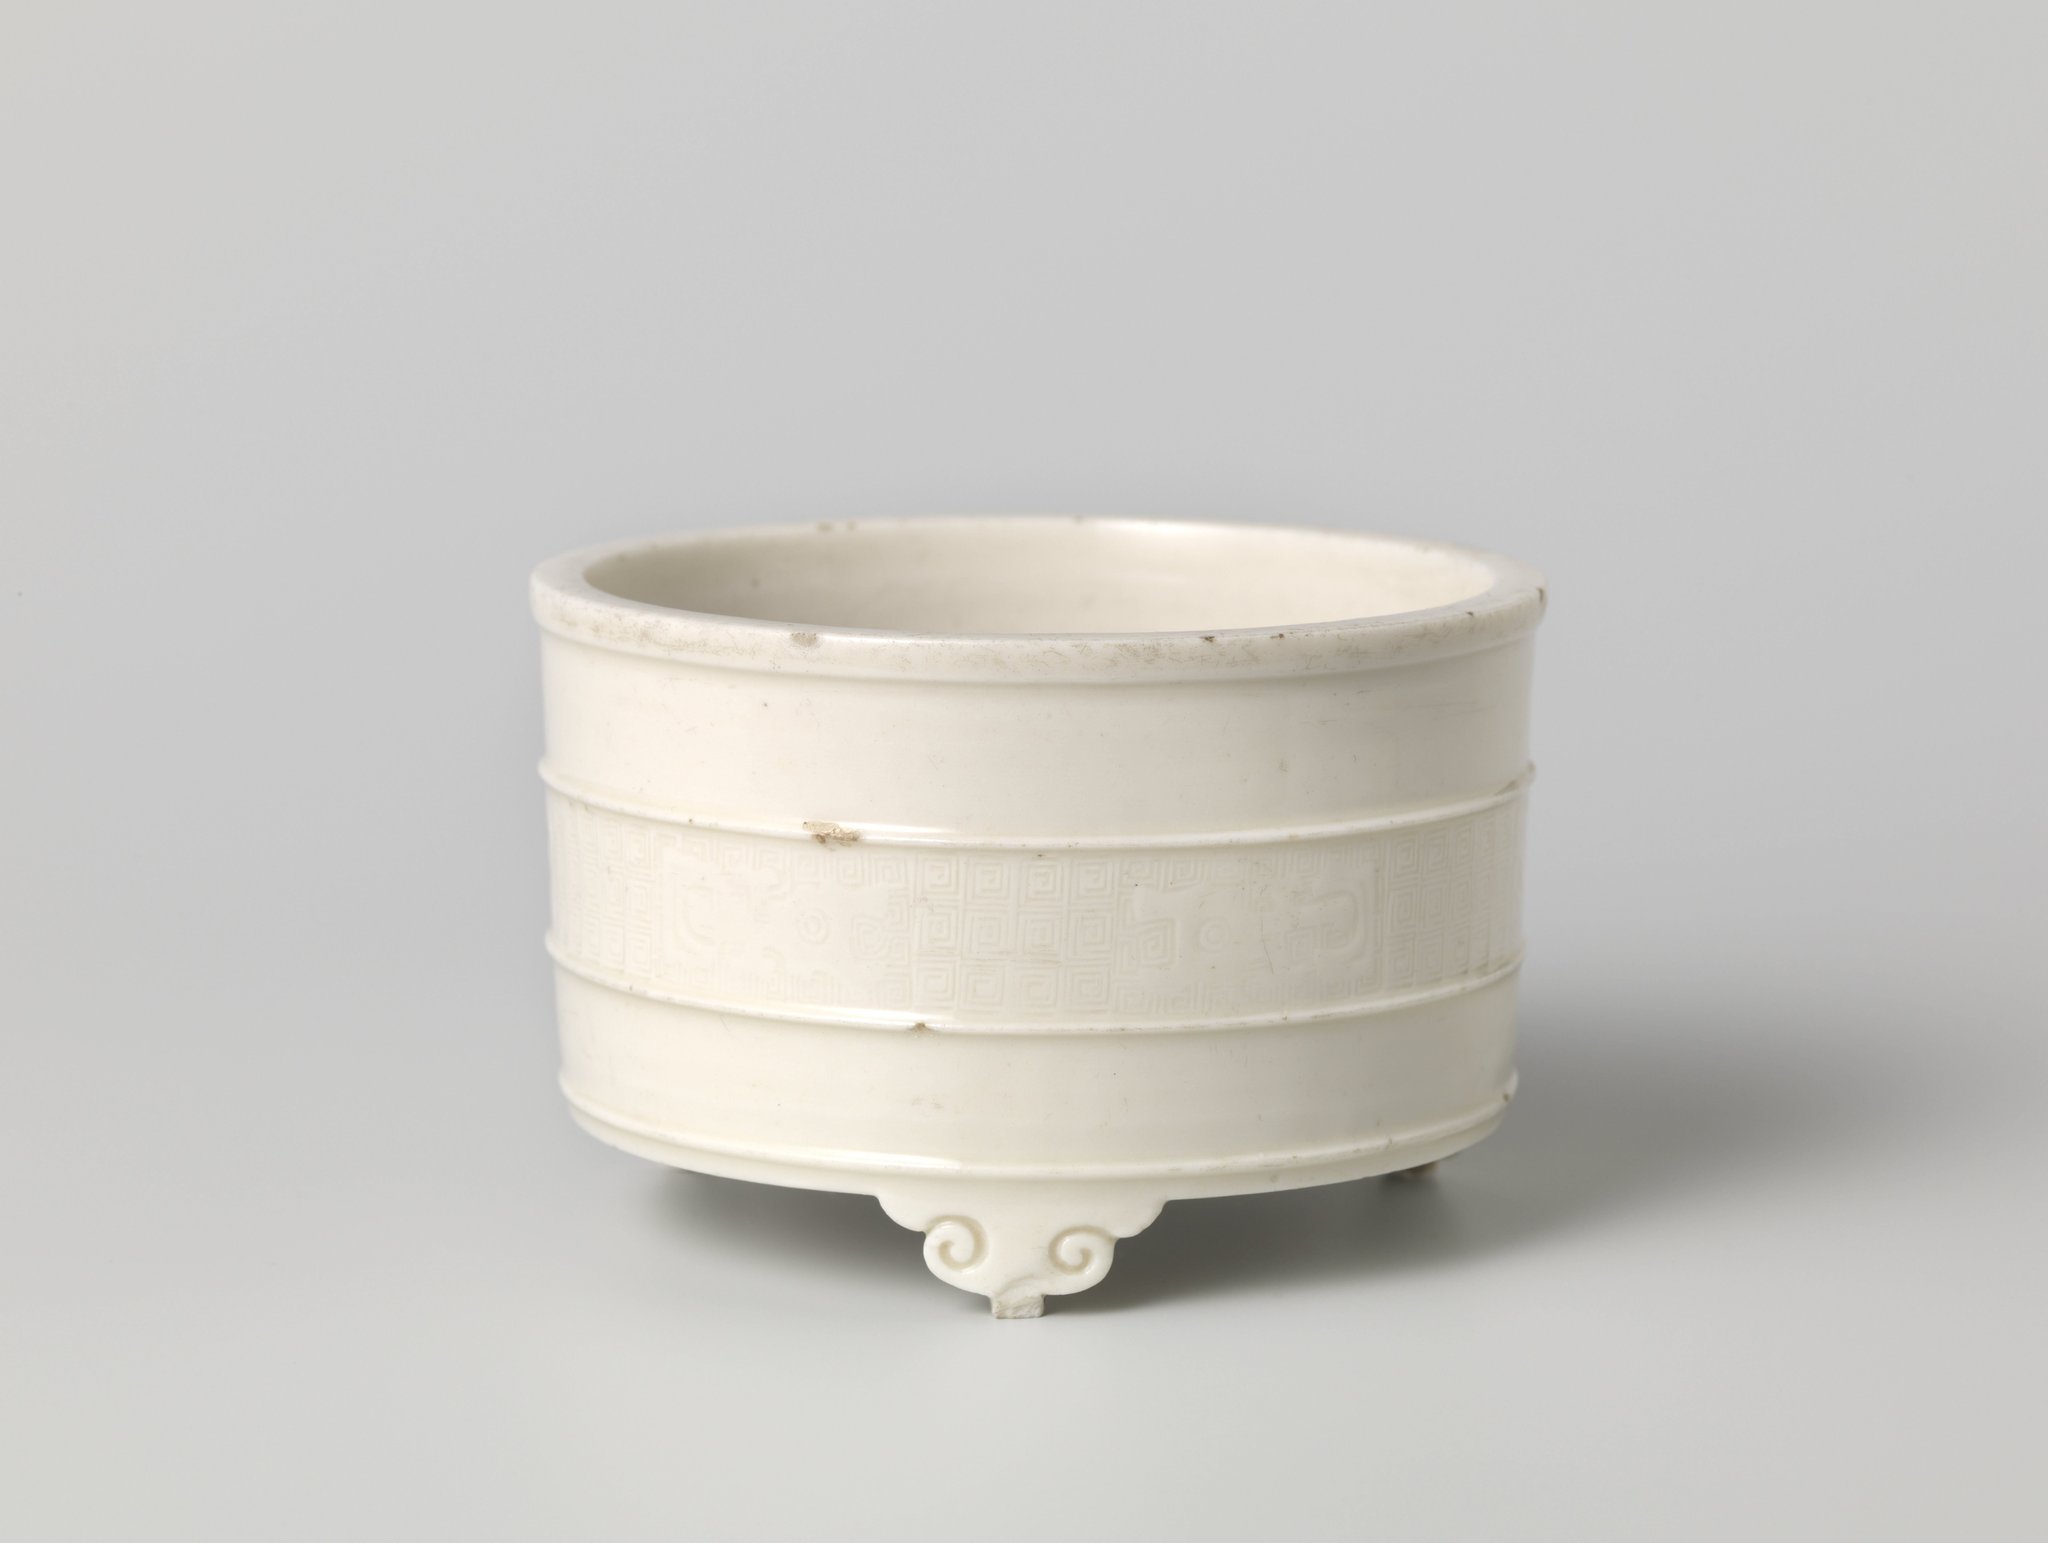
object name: incense burner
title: Insence burner with incised geometric pattern and three ruyi-shaped feet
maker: Anonymous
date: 1625-1675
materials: glaze, porcelain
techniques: firing, forming, turning, vitrification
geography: china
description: Rond wierookbakje van porselein. 'Blanc de Chine'. Versierd met drie horizontale banden waarvan de middelste versierd is met ingegrift meander-motief. De drie platte pootjes hebben de vorm van de kop van de 'Ju-I-scepter'.